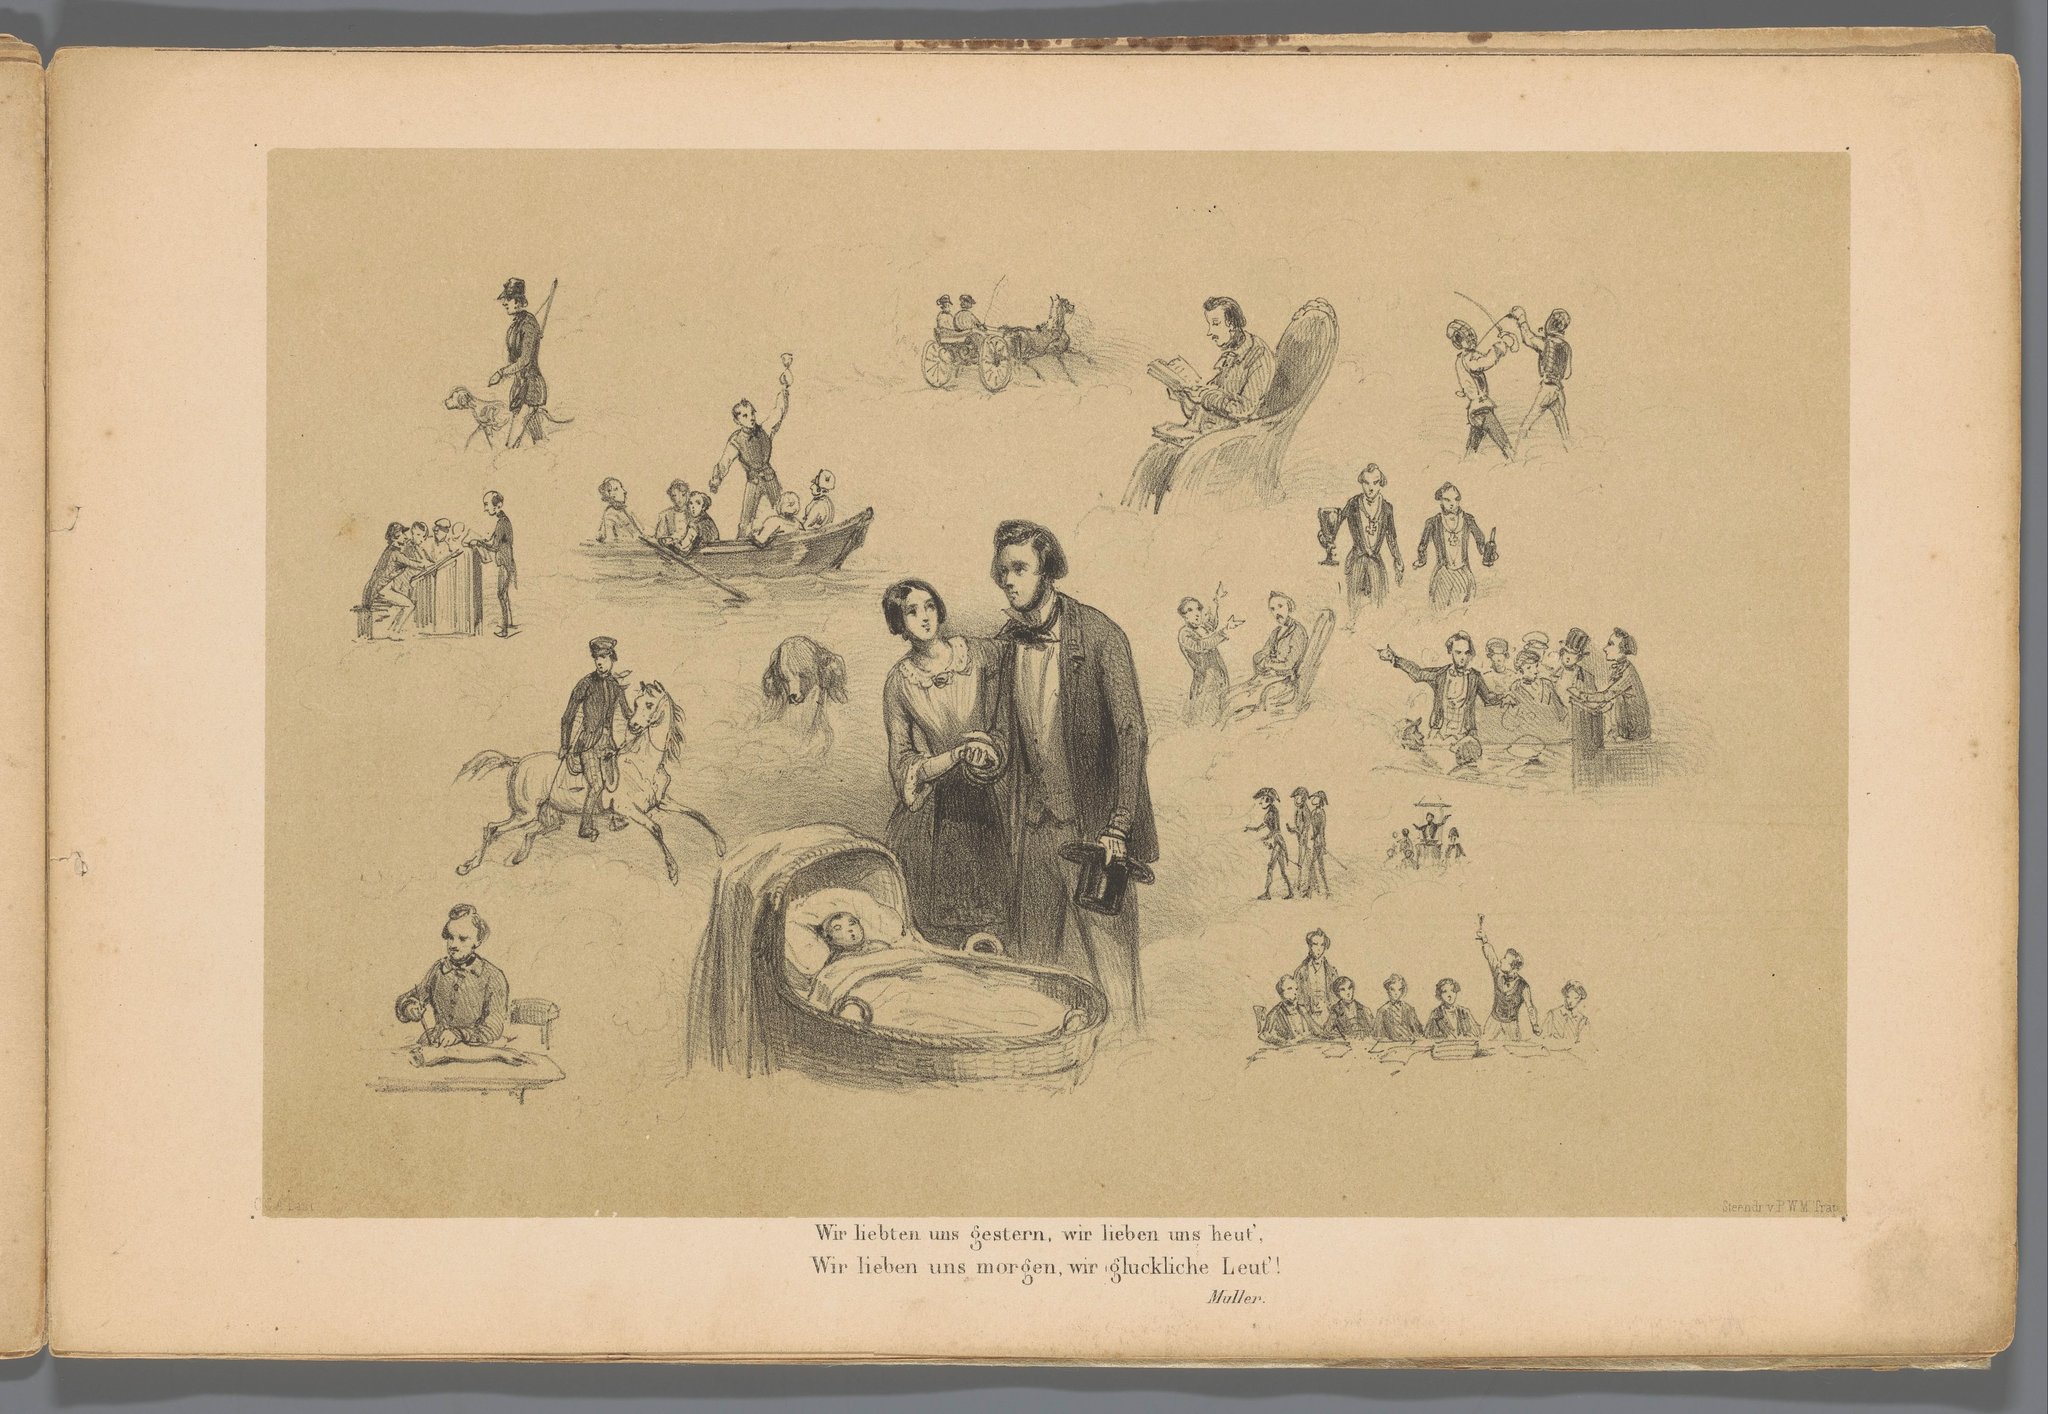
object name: print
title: Man en vrouw bij een wieg met baby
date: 1836-1876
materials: paper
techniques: tone lithography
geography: leiden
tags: marriage, married couple, 'matrimonium', cradle, crib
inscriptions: collector's mark: Lugt 2228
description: De serie met omslag werd samengesteld door Jan van der Hoeven (Leiden 1834 - Rotterdam 1900). Van der Hoeven was mede oprichter van het Sophia-Kinderziekenhuis in Rotterdam en was als heelmeester verbonden aan het stedelijk ziekenhuis aldaar.